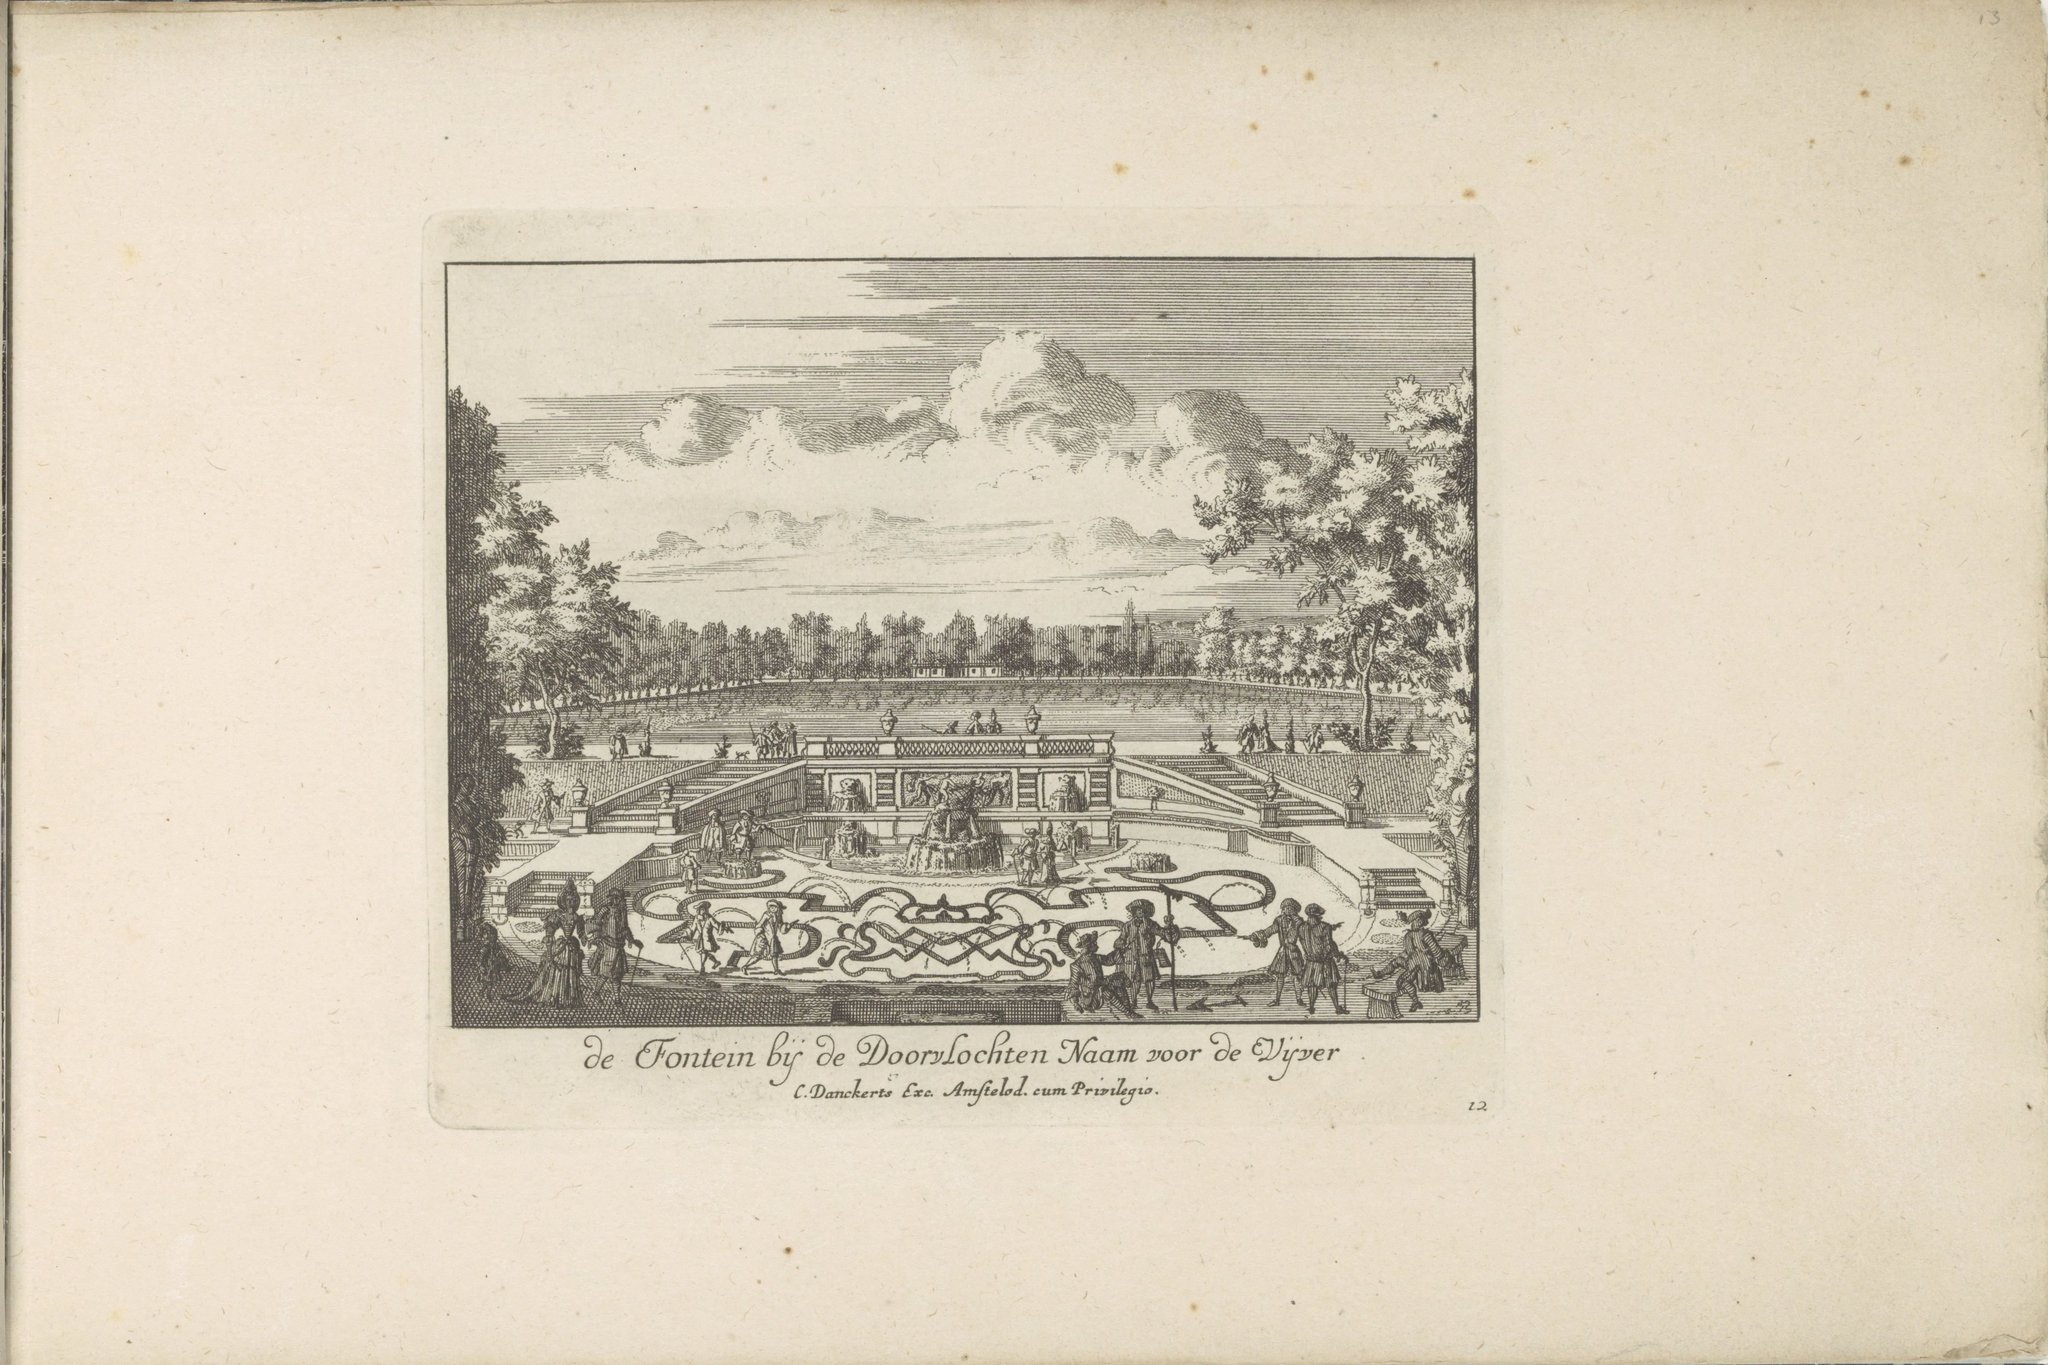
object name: album leaf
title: Gezicht op de tuin van Paleis Het Loo met op de voorgrond het monogram van Willem III prins van Oranje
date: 1696-1718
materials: paper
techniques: etching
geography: amsterdam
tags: palace, french or architectonic garden; formal garden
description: Gezicht op de tuin van Paleis Het Loo met op de voorgrond het monogram van Willem III (prins van Oranje en koning van Engeland, Schotland en Ierland). Prent maakt deel uit van een album.